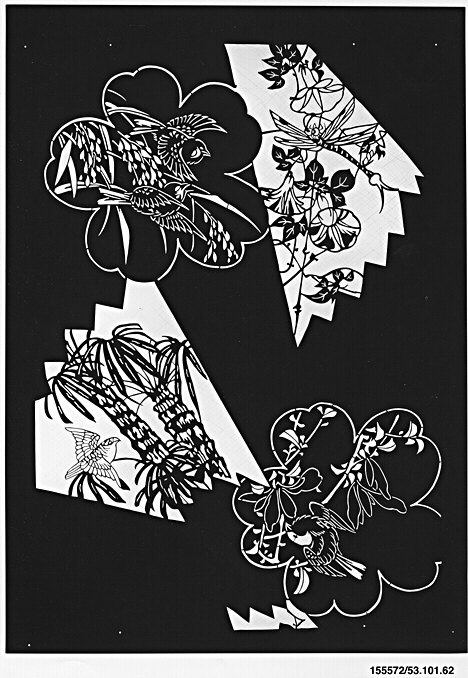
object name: stencil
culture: japanese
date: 1615-1868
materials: paper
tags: birds,dragonflies